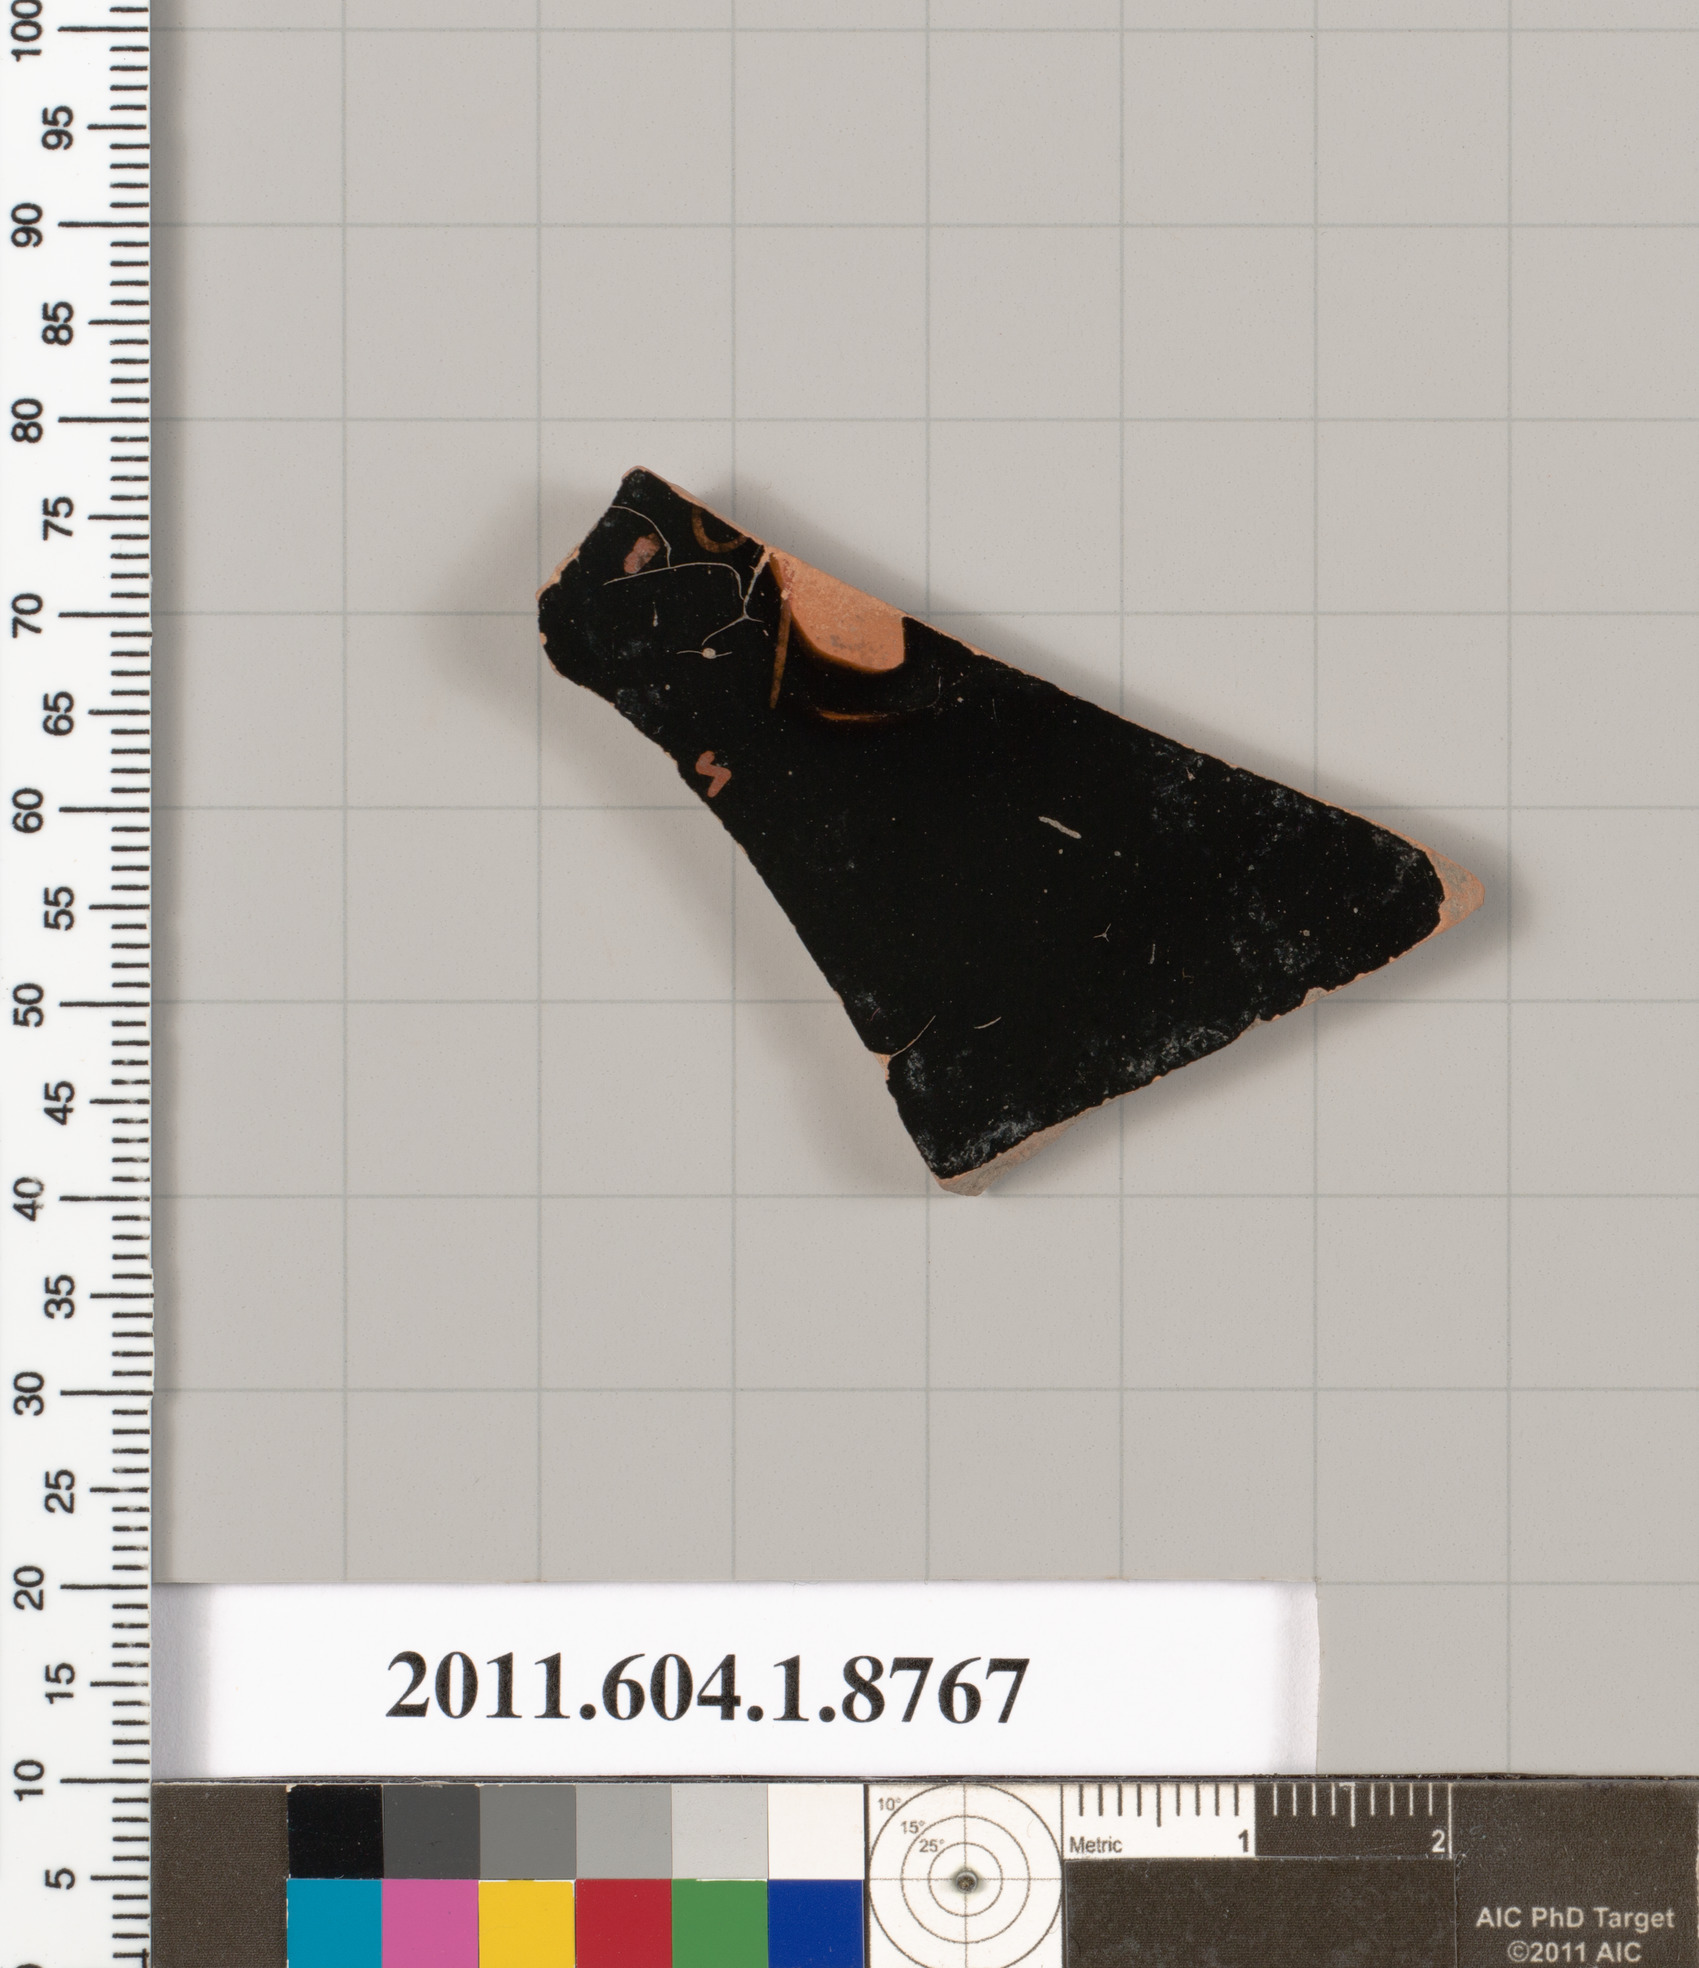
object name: kylix fragment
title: Terracotta fragment of a kylix (drinking cup)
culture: greek, attic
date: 490-470 BCE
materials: terracotta